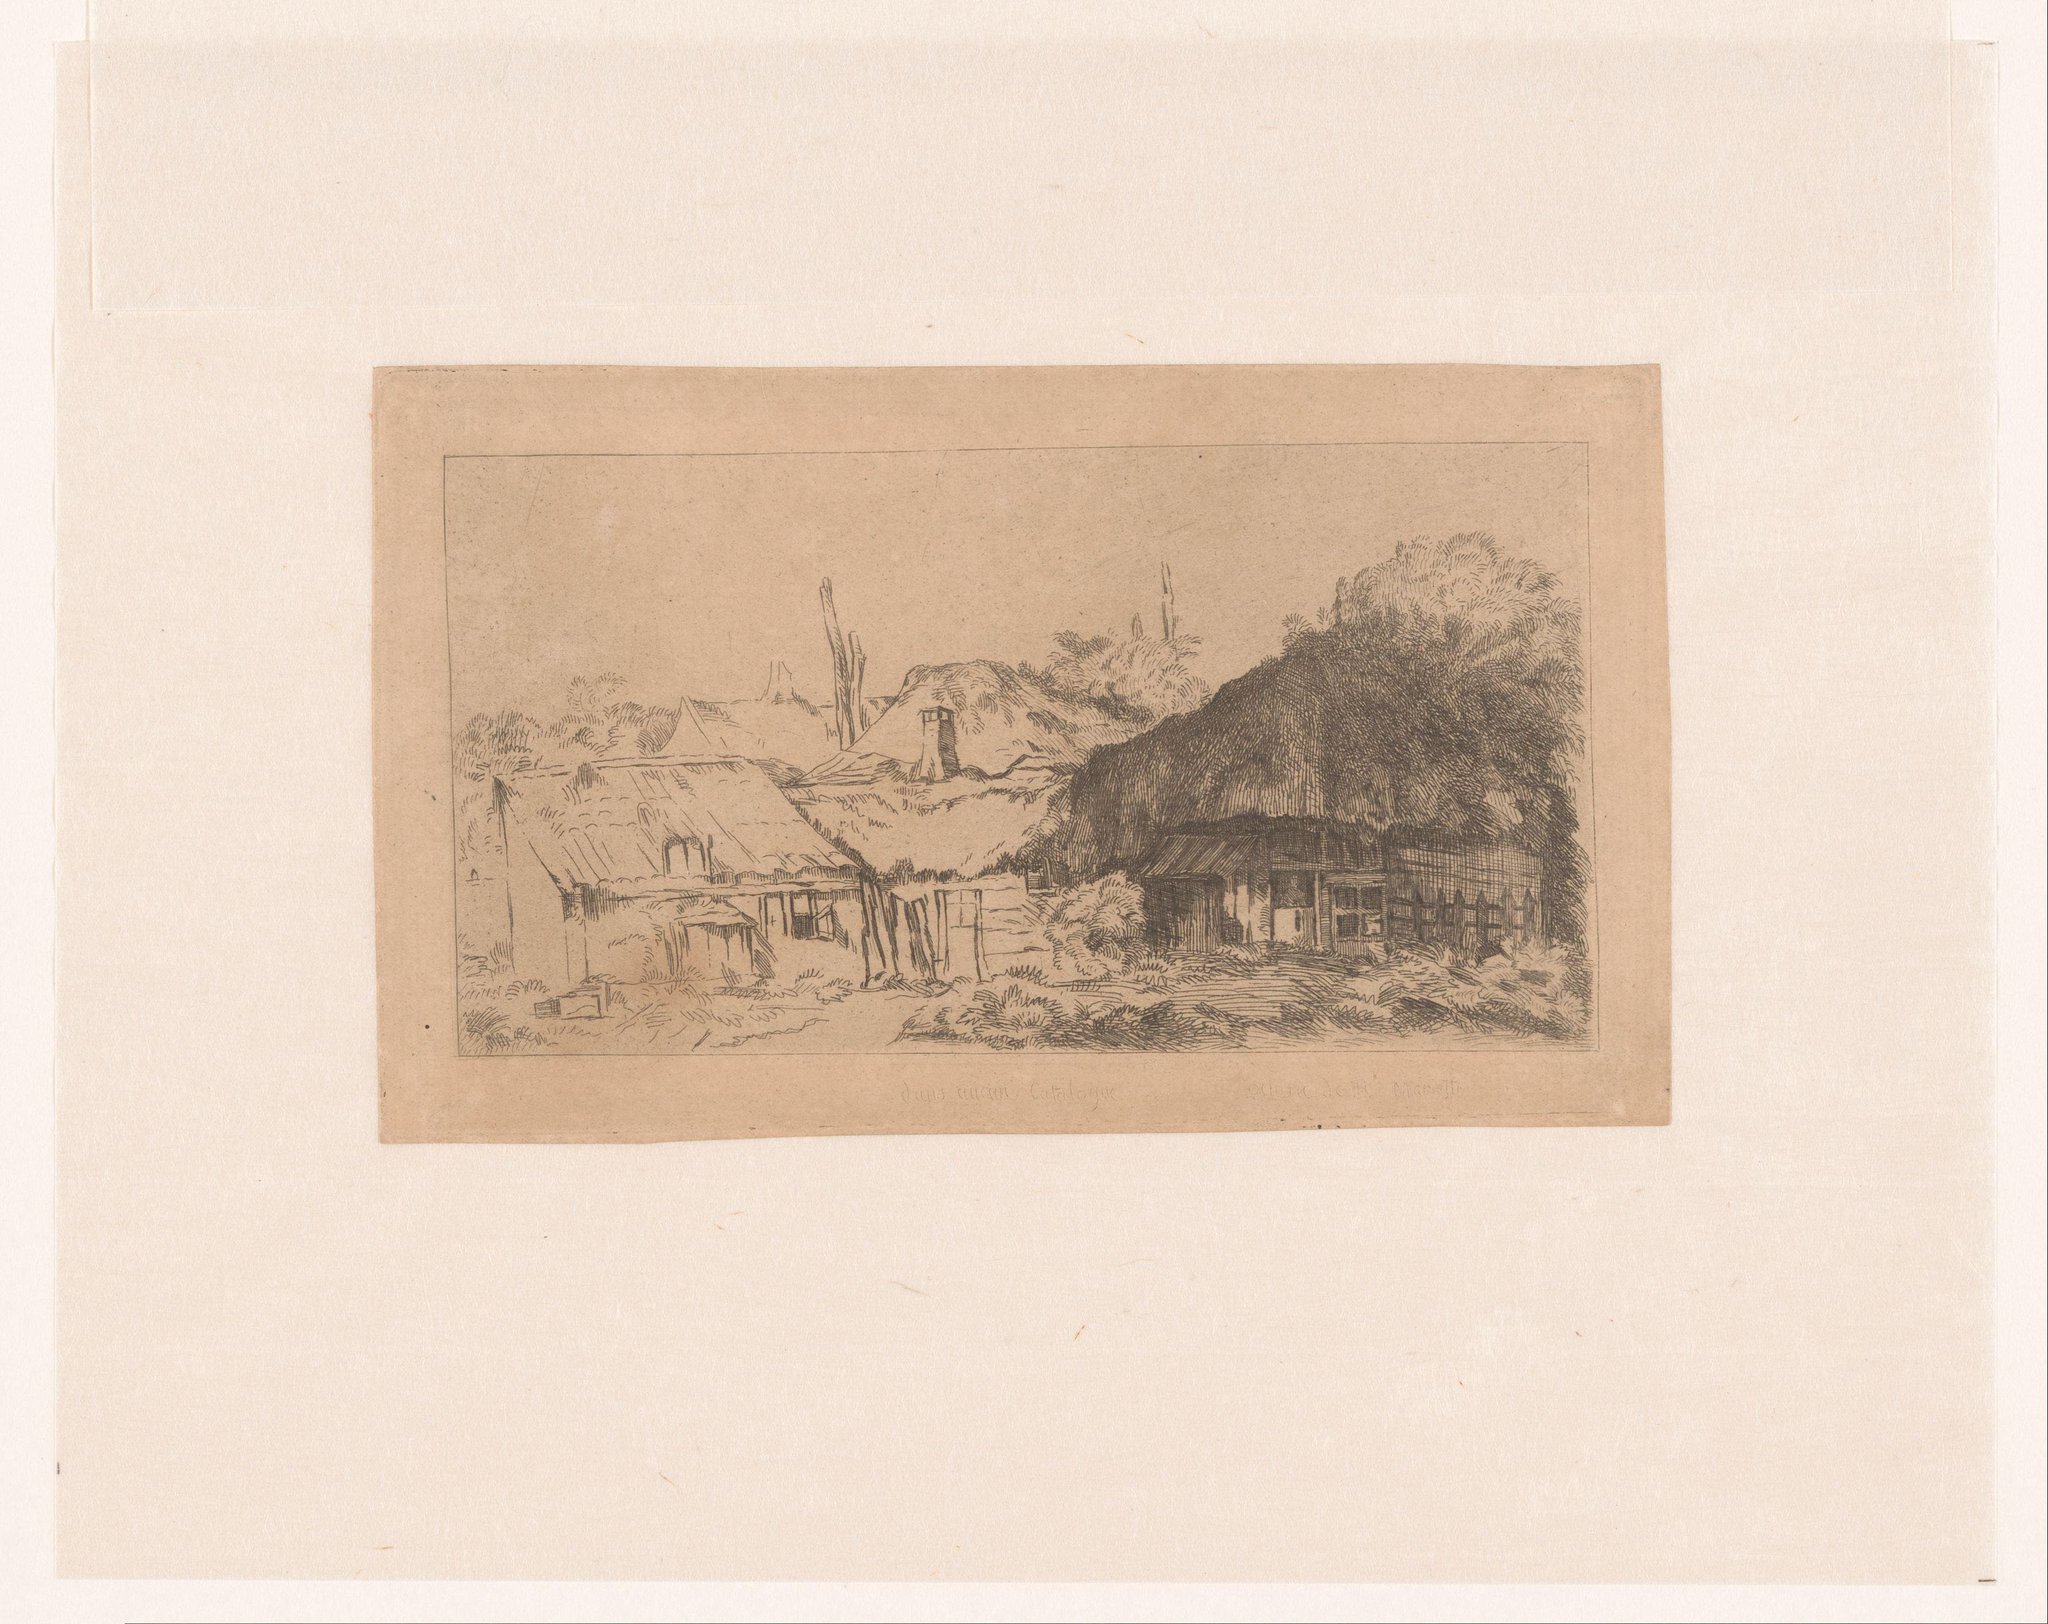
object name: print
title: Onvoltooid landschap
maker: pierre françois basan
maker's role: print maker, publisher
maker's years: 1723-1797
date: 1733-1797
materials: paper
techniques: etching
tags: landscapes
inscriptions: collector's mark: Lugt 2228, collector's mark: Lugt 2760